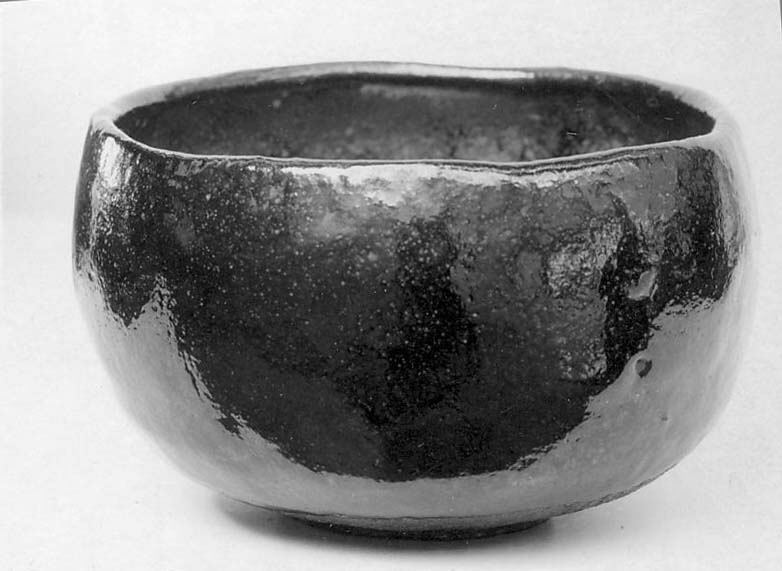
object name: teabowl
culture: japanese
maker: tokunyu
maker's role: artist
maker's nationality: japanese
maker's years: 1675-1775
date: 1770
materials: glaze, pottery